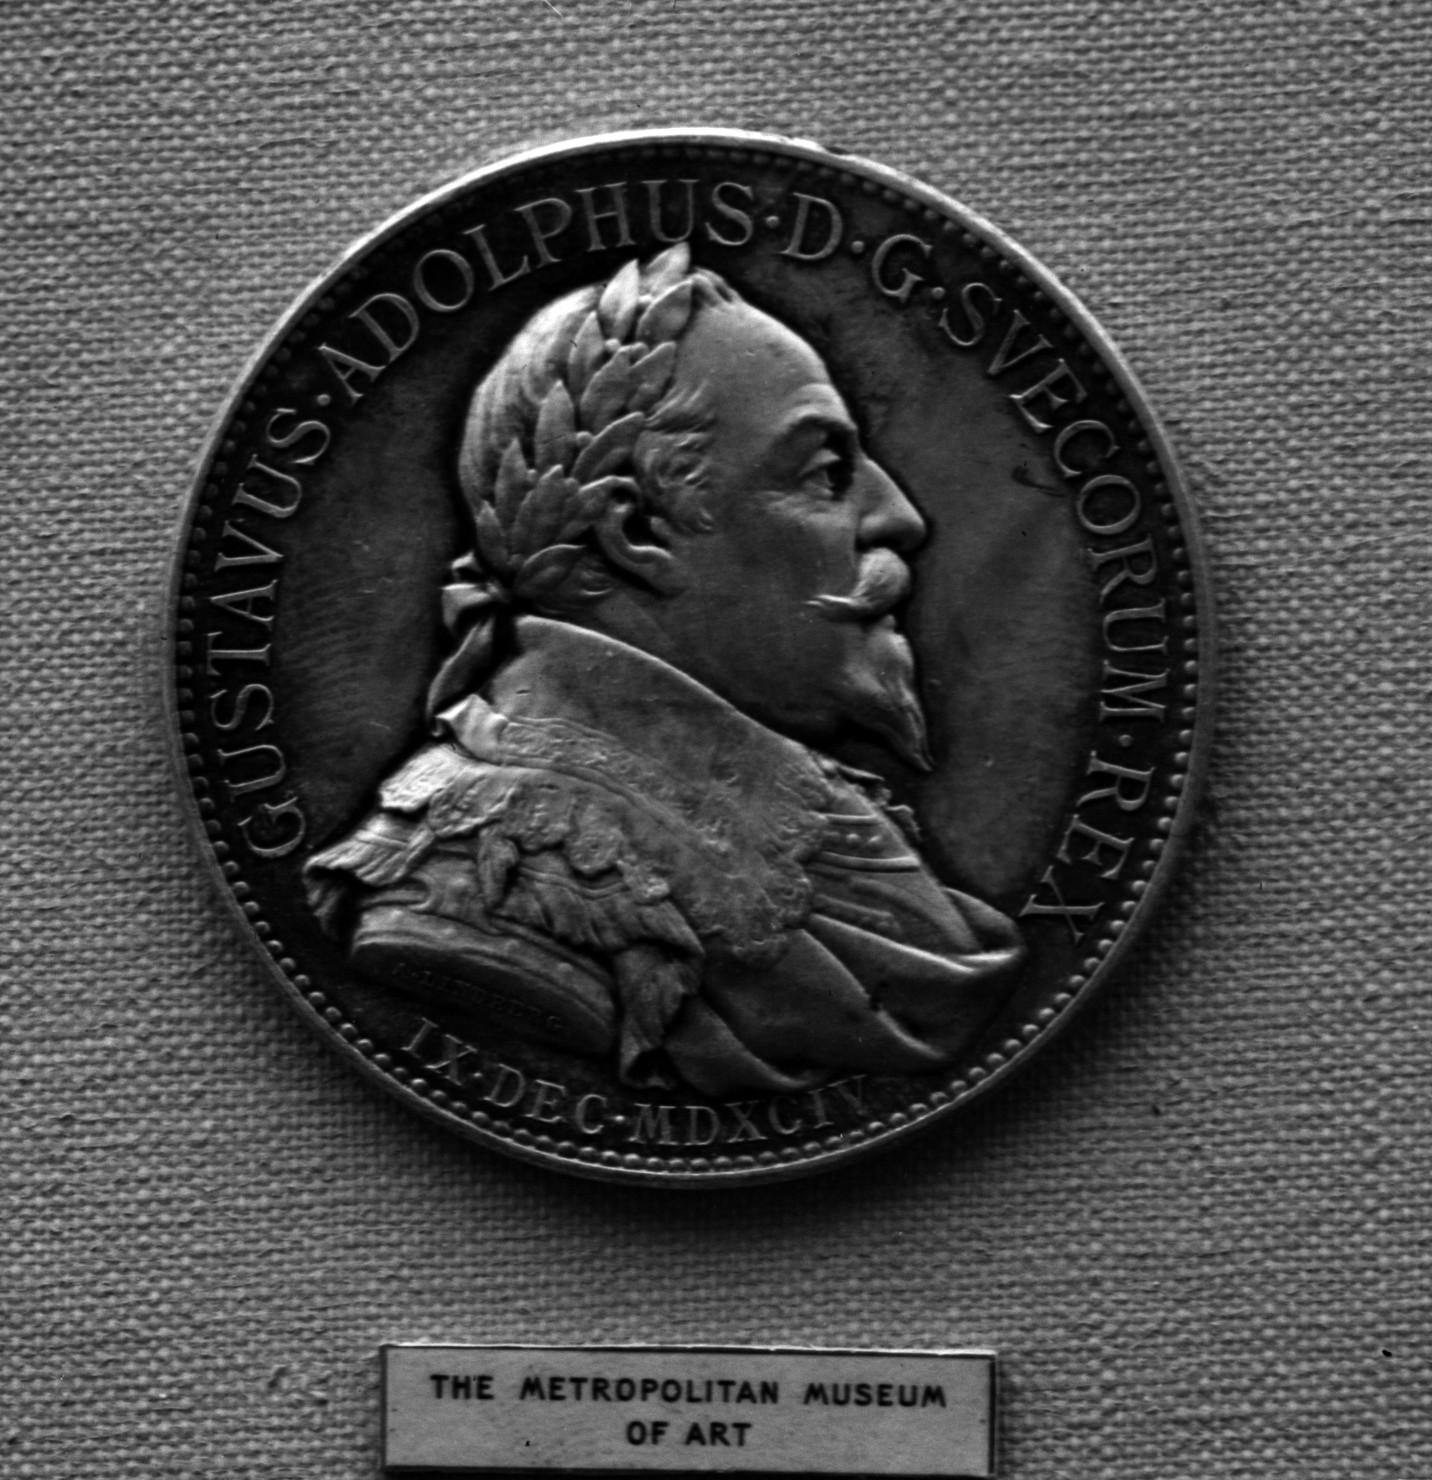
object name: medal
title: In Honor of the 300th Anniversary of the Birth of Gustavus Adolphus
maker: adolf lindberg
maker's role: artist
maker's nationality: swedish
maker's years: 1839-1916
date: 1801-1900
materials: silver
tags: men,profiles